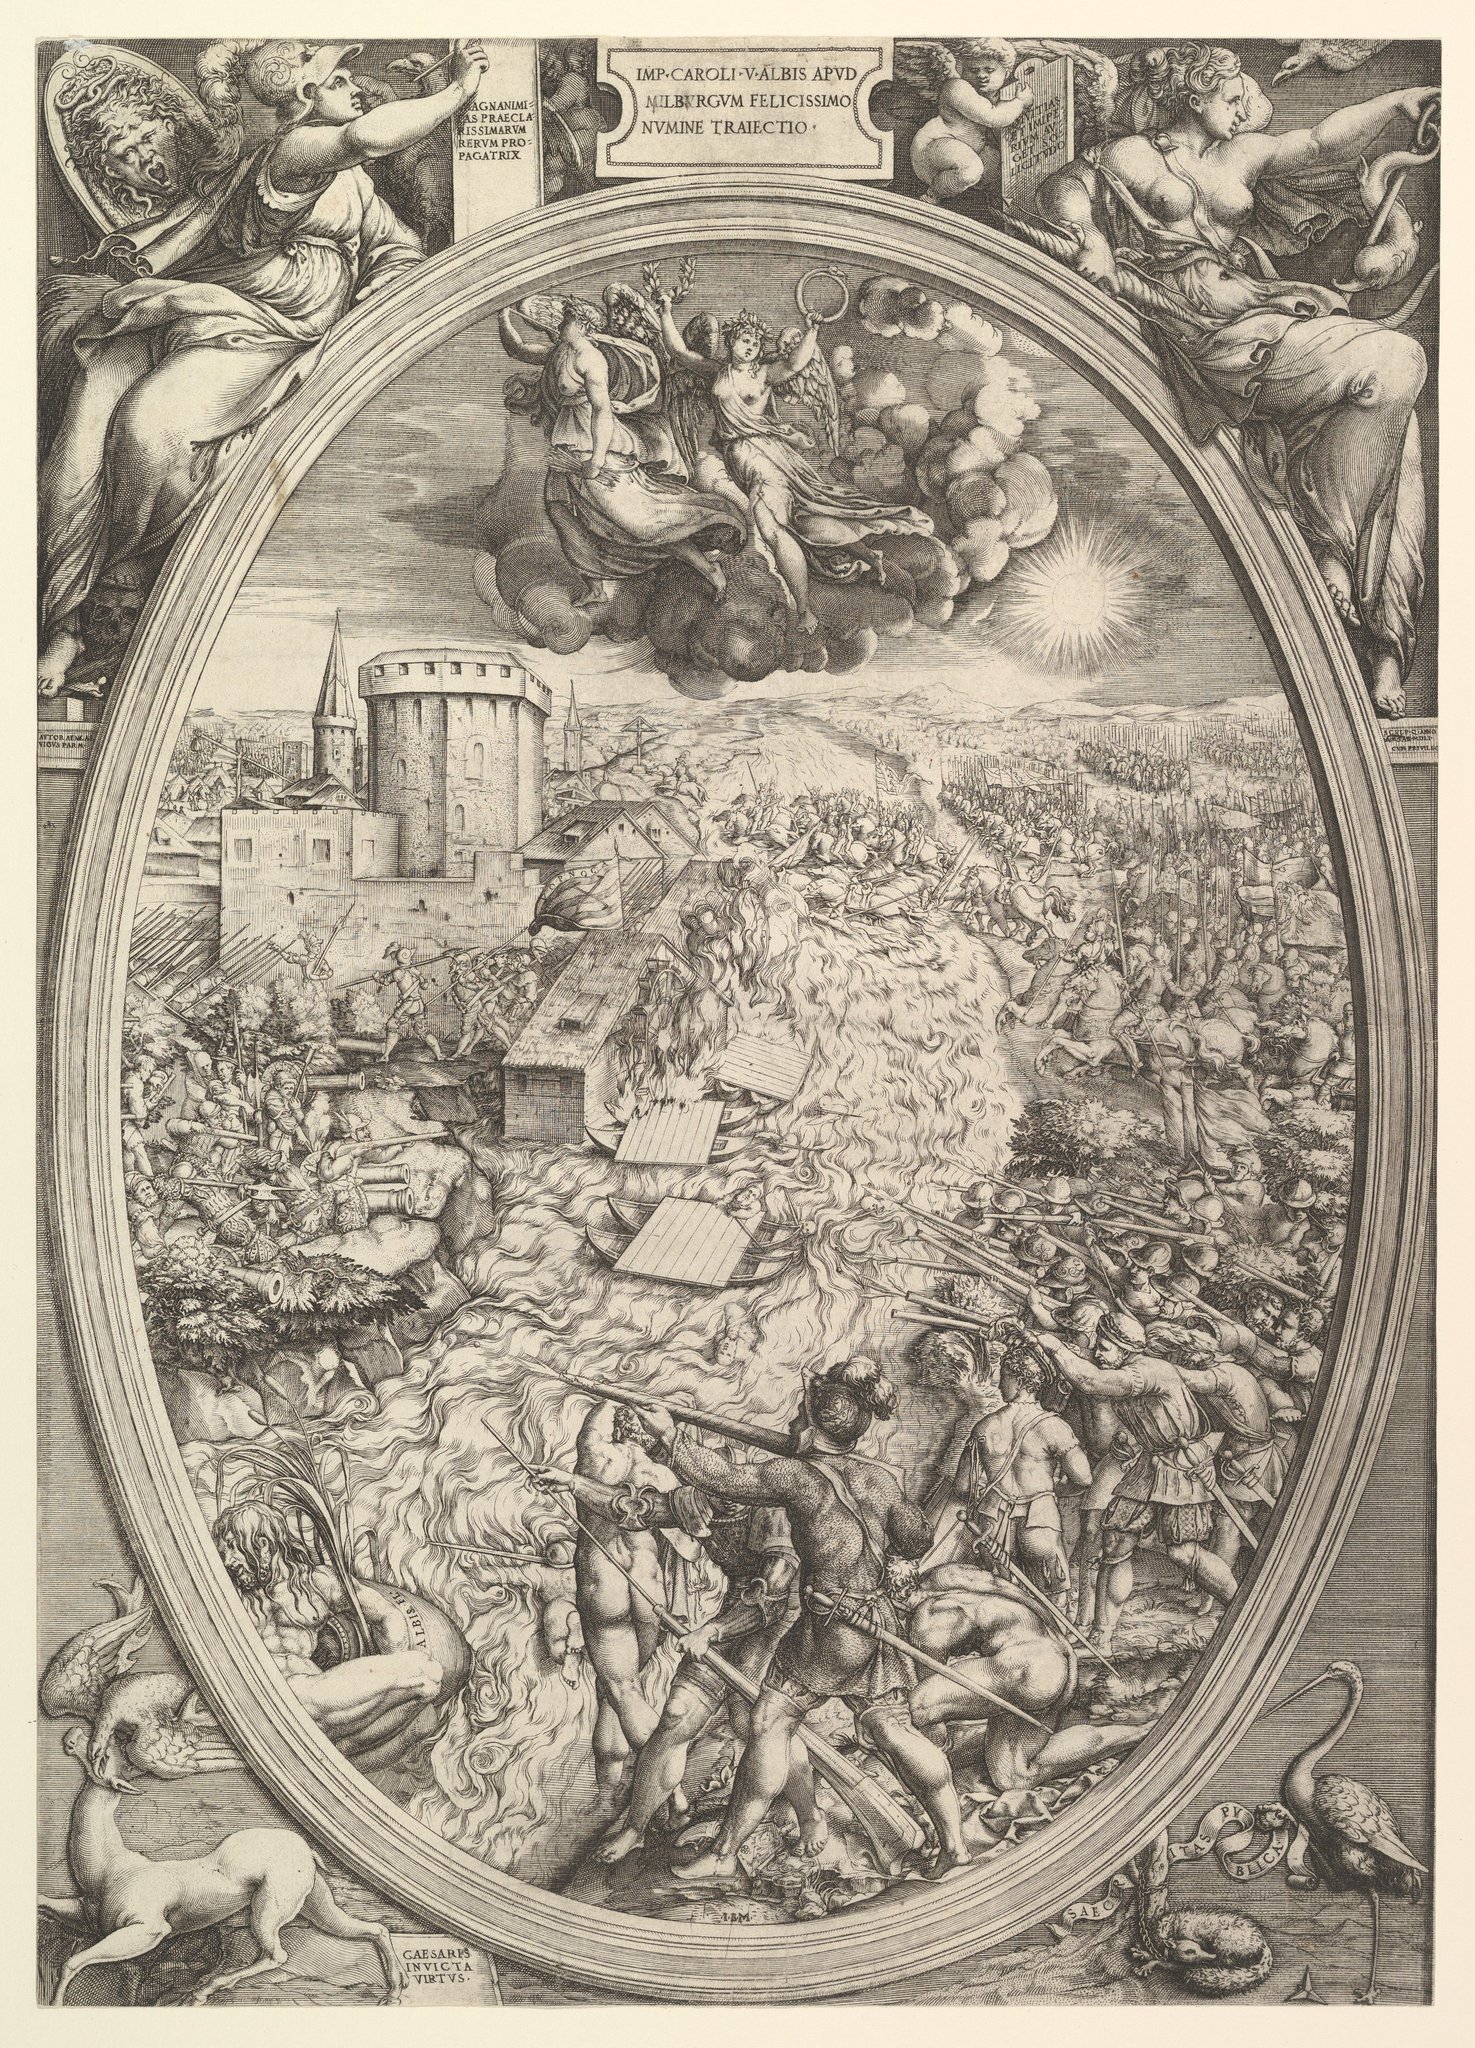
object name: print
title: The Battle of Mühlberg with the army of Charles V crossing the Elbe River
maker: enea vico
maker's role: artist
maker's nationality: italian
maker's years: 1523-1567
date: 1551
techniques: engraving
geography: mantua or venice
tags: battles,army,firearms,rivers